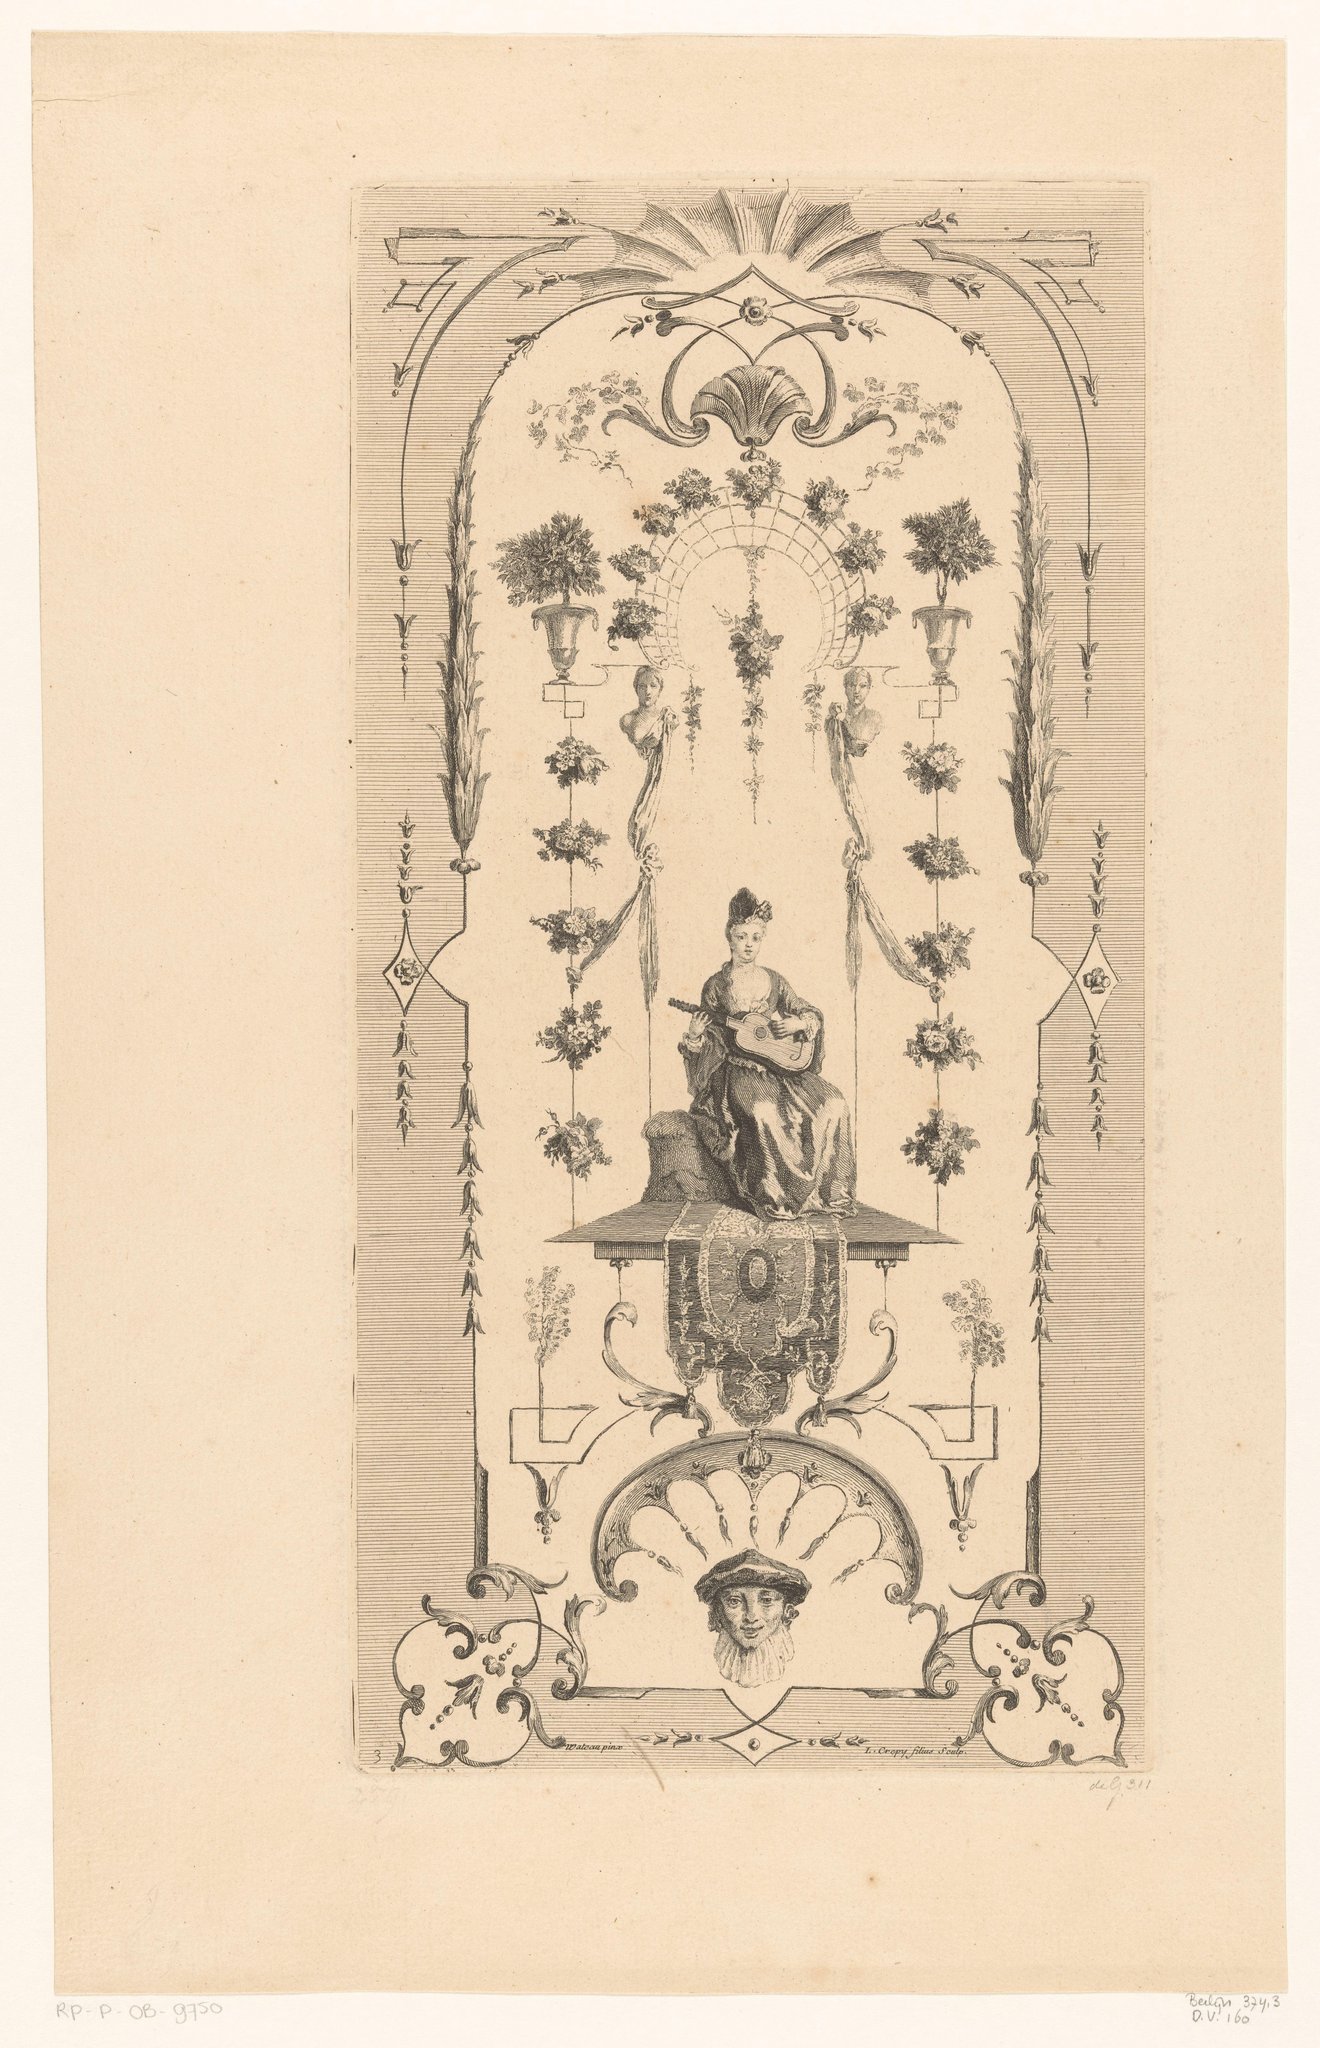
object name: print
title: Kamerscherm met zes bladen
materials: paper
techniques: etching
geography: paris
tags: making music; musician with instrument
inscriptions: collector's mark: Lugt 2228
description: Een vrouw zit op een verhoging en speelt op een gitaar. Rondom de voorstelling een ornamentele omlijsting met schelpmotieven, bloemen, vazen, bustes en een masker.